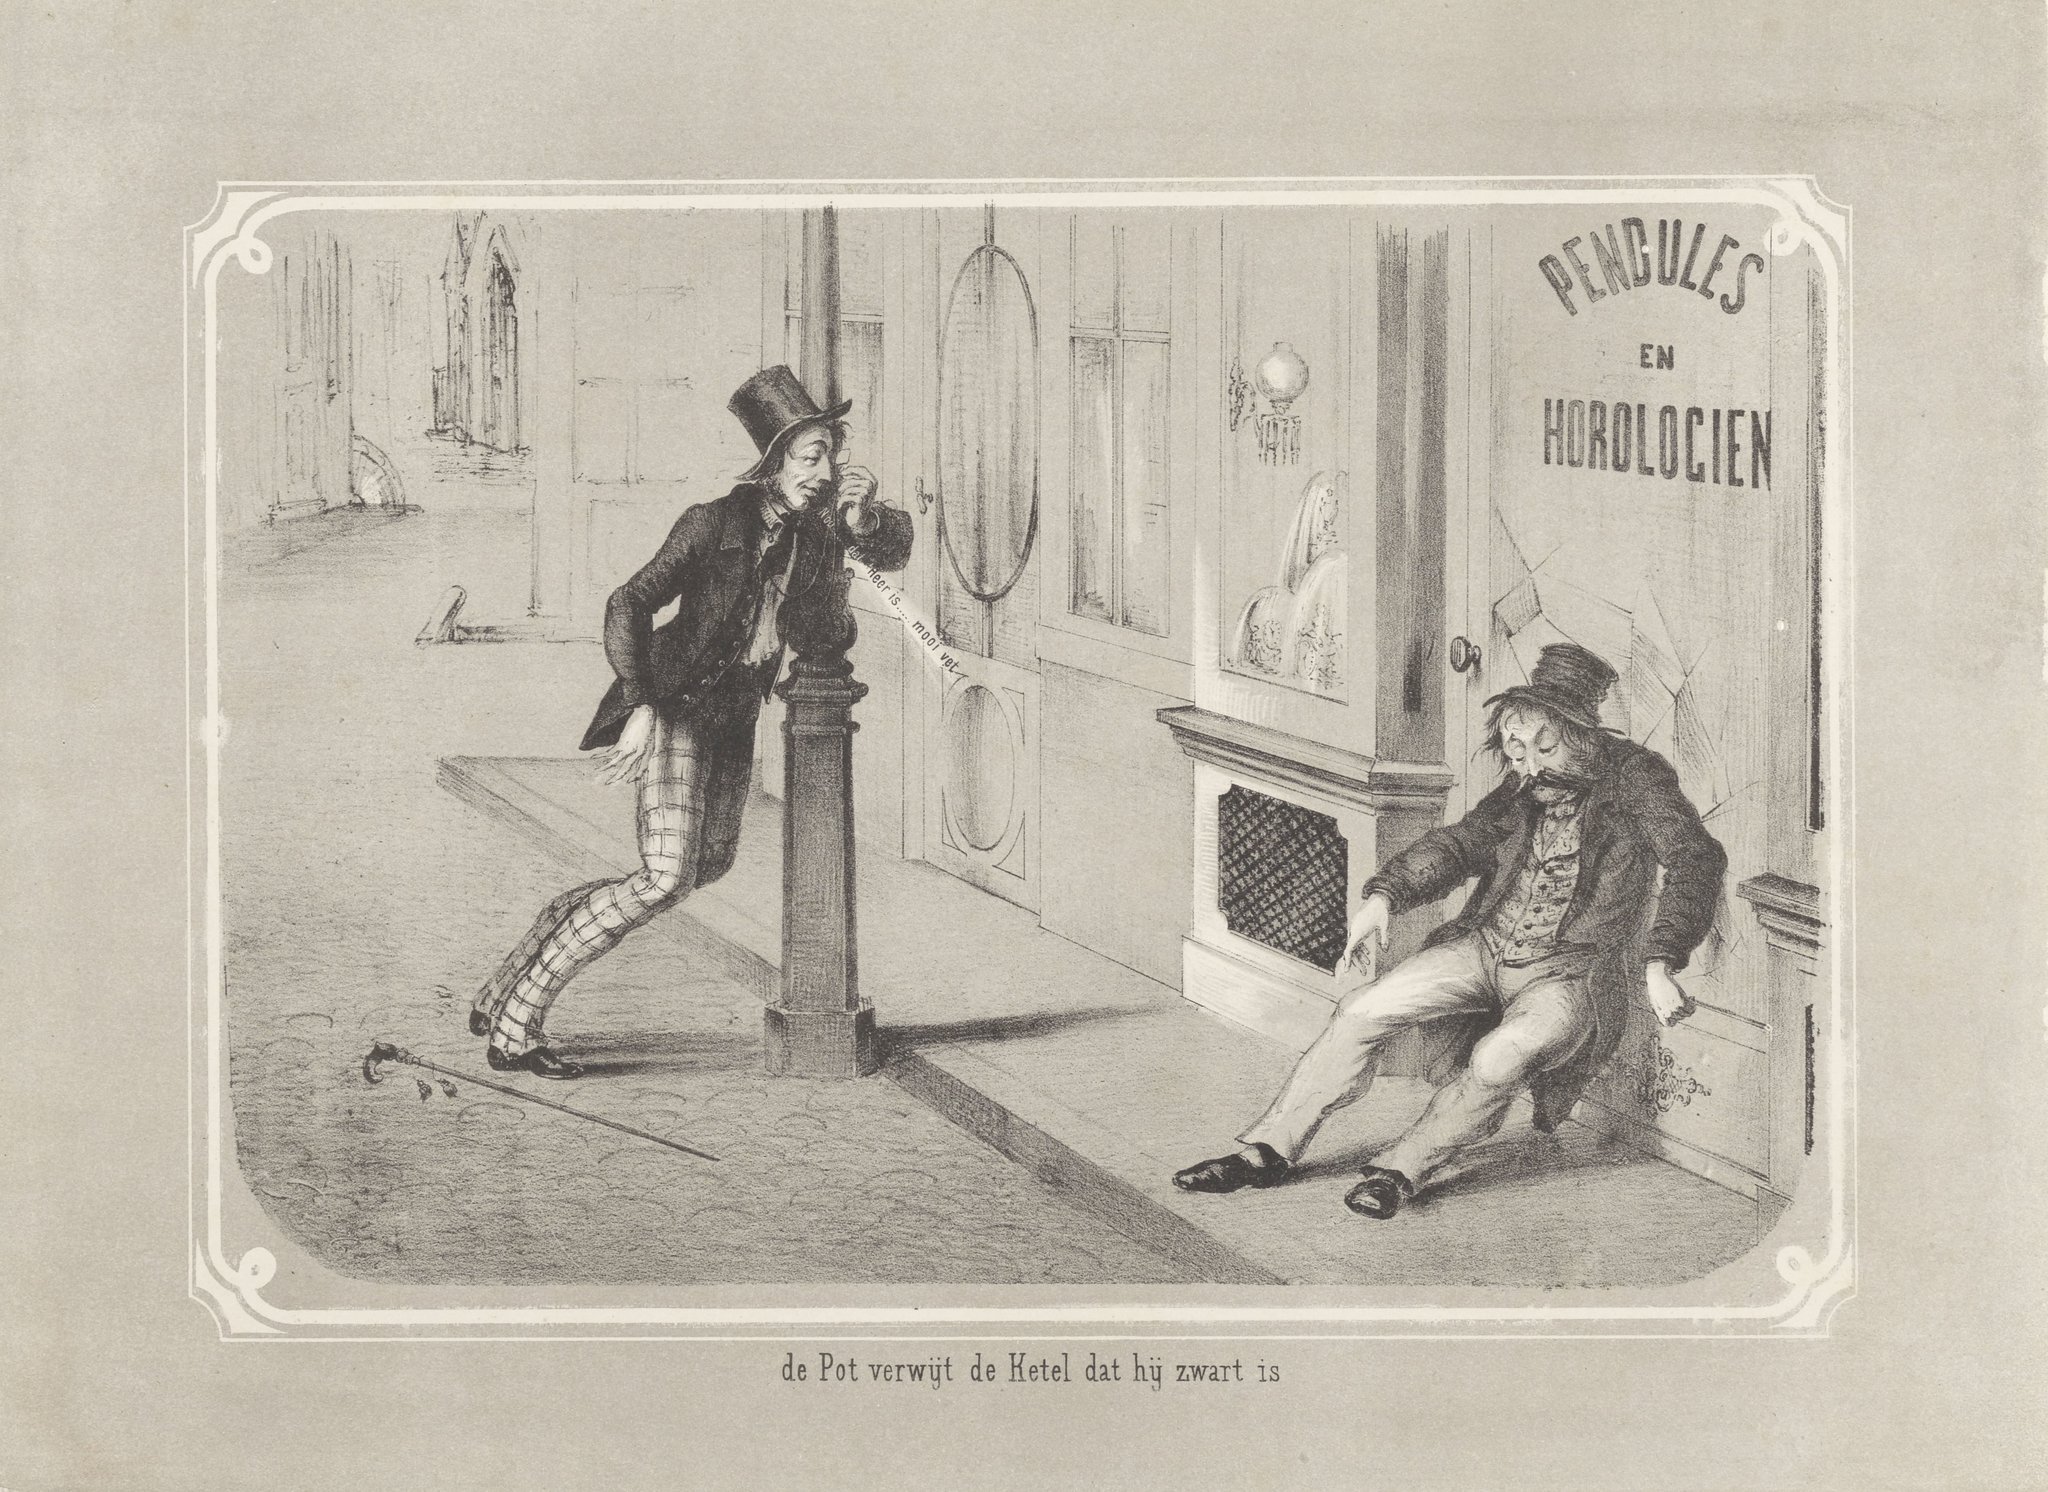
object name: print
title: Twee dronken mannen op straat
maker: gustaaf leonardus adolf amand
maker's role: print maker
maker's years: 1833-1897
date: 1867-1894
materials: paper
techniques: tone lithography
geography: amsterdam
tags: shop, store, drunkard, proverbs, sayings, etc., street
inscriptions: collector's mark: Lugt 2228, collector's mark: Lugt 2760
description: Verbeelding van het spreekwoord: de pot verwijt de ketel dat hij zwart is. Op straat is een dronken man tegen de pui van een winkel aan gevallen. Een andere dronken man leunt tegen een lantaarnpaal en zegt: "Nou... dat Heer is ... mooi vet". Zijn wandelstok ligt op de grond.